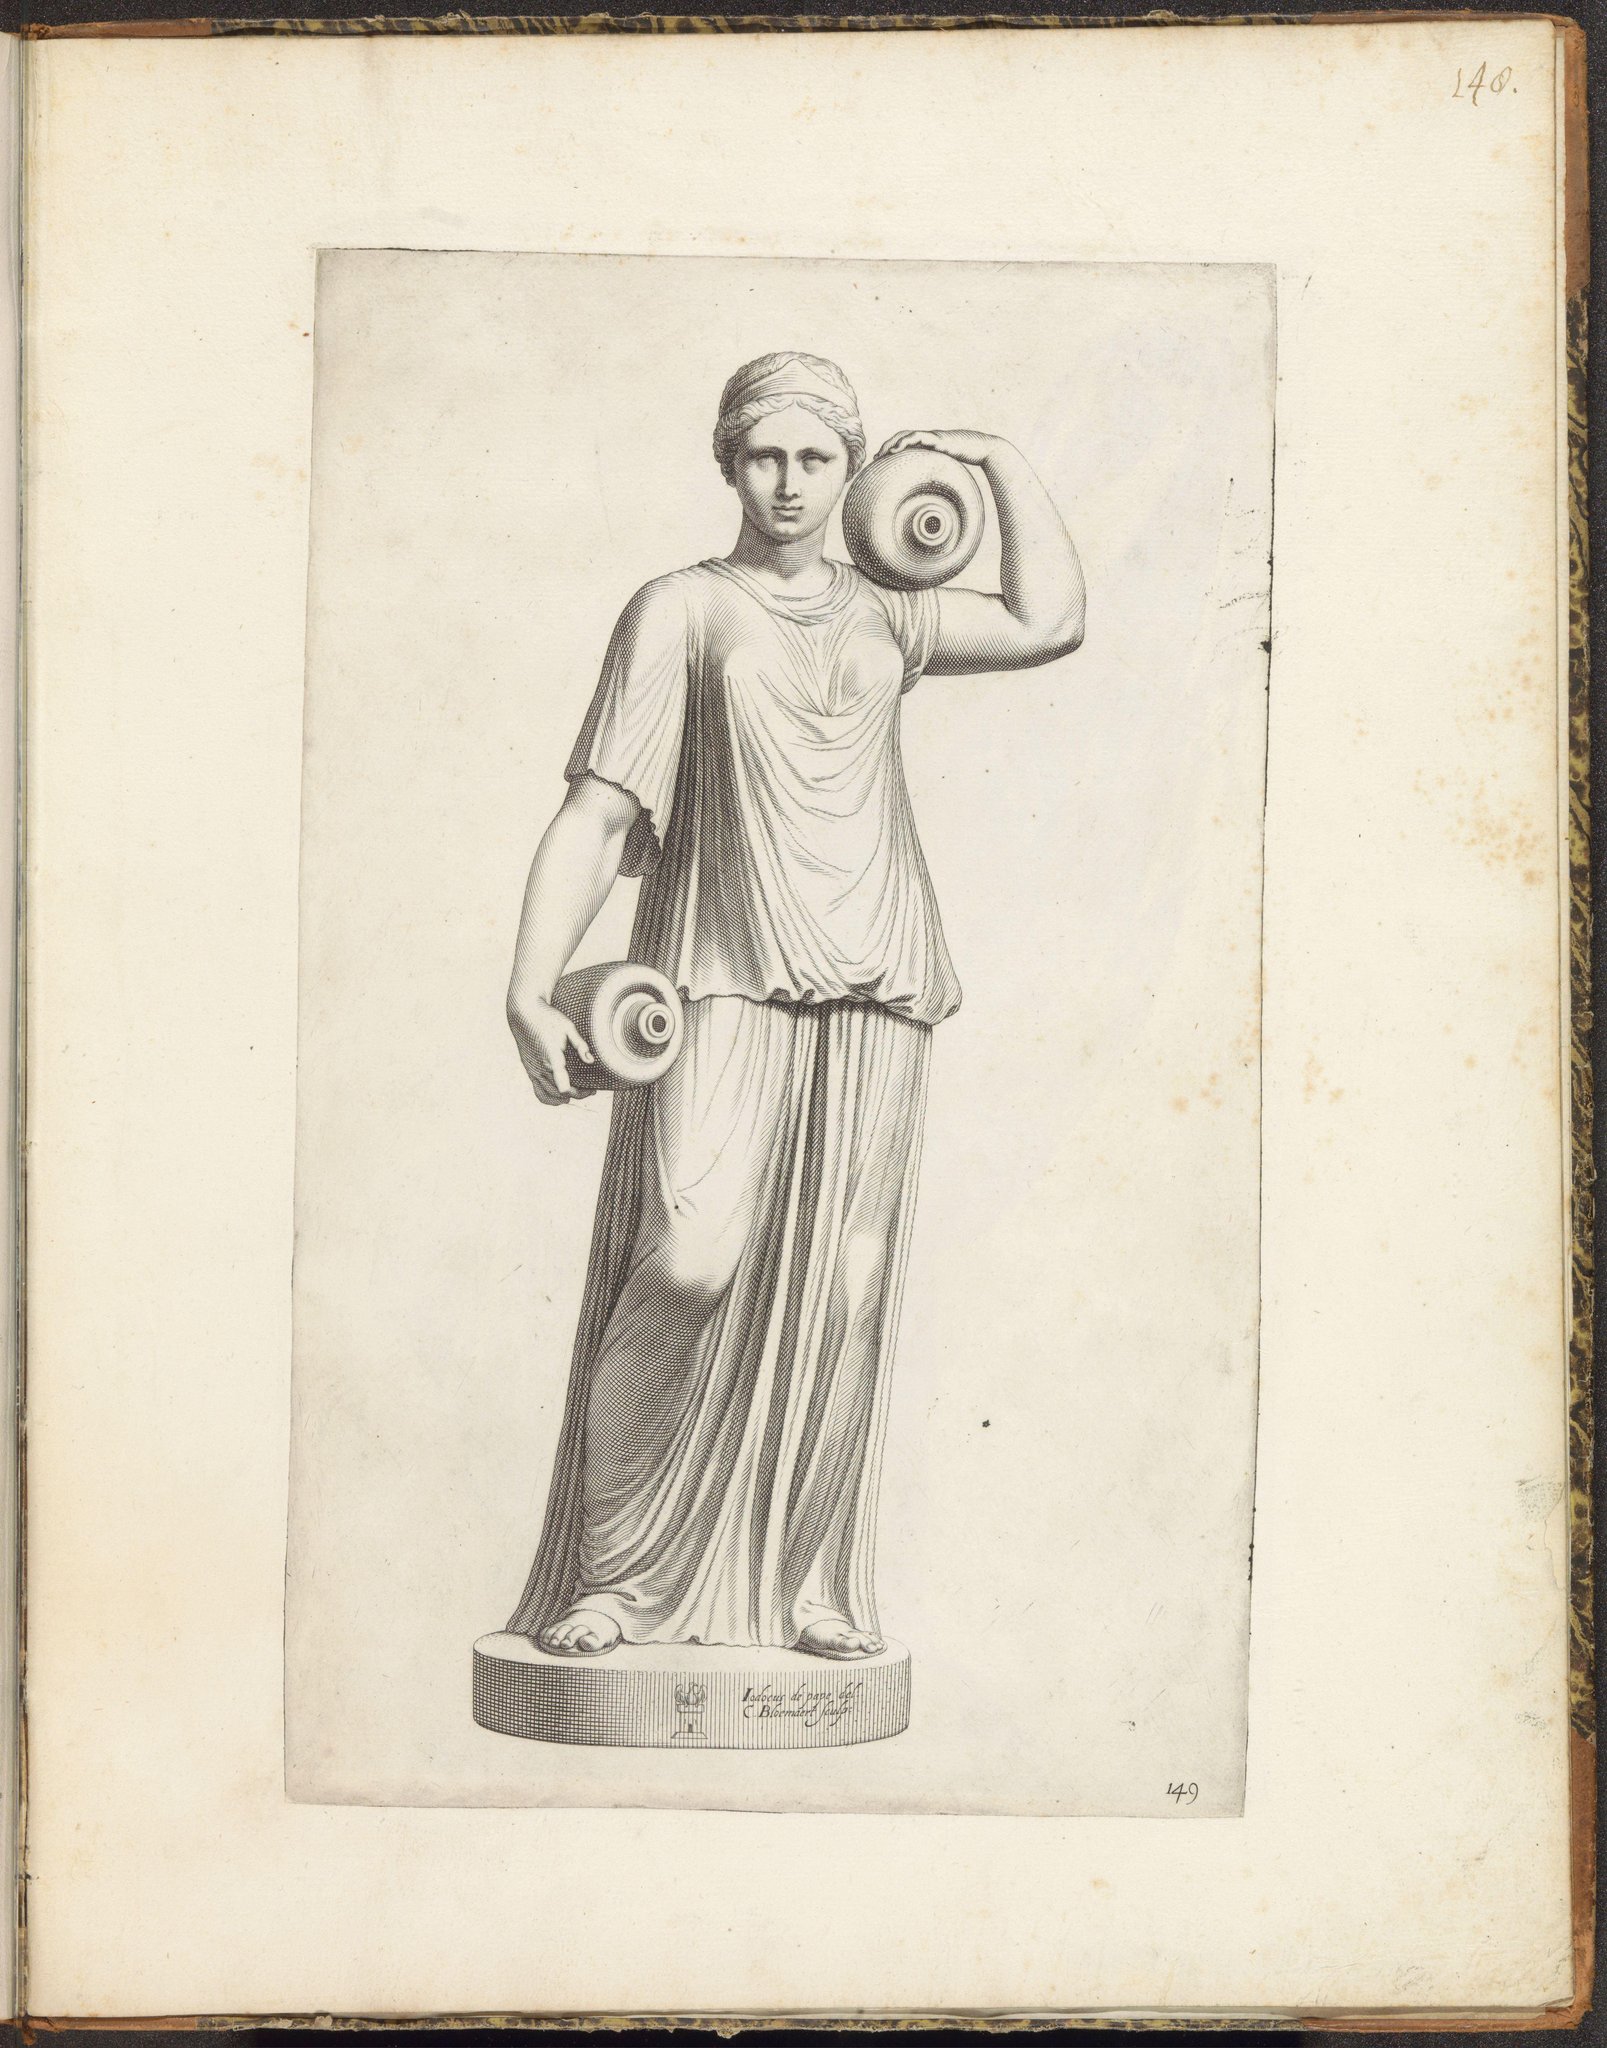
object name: album leaf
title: Galleria Giustiniana del Marchese Vincenzo Giustiniani I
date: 1636-1647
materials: paper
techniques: engraving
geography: rome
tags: piece of sculpture, reproduction of a piece of sculpture, female persons from classical history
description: Standbeeld van een vrouw die twee vazen draagt, één op de schouder en één op de heup. Midden onder op de basis het wapenschild van Vincenzo Giustiniani. Prent maakt deel uit van een album met een serie prenten naar de sculpturen in de verzameling in de Galleria Giustiniani te Rome.